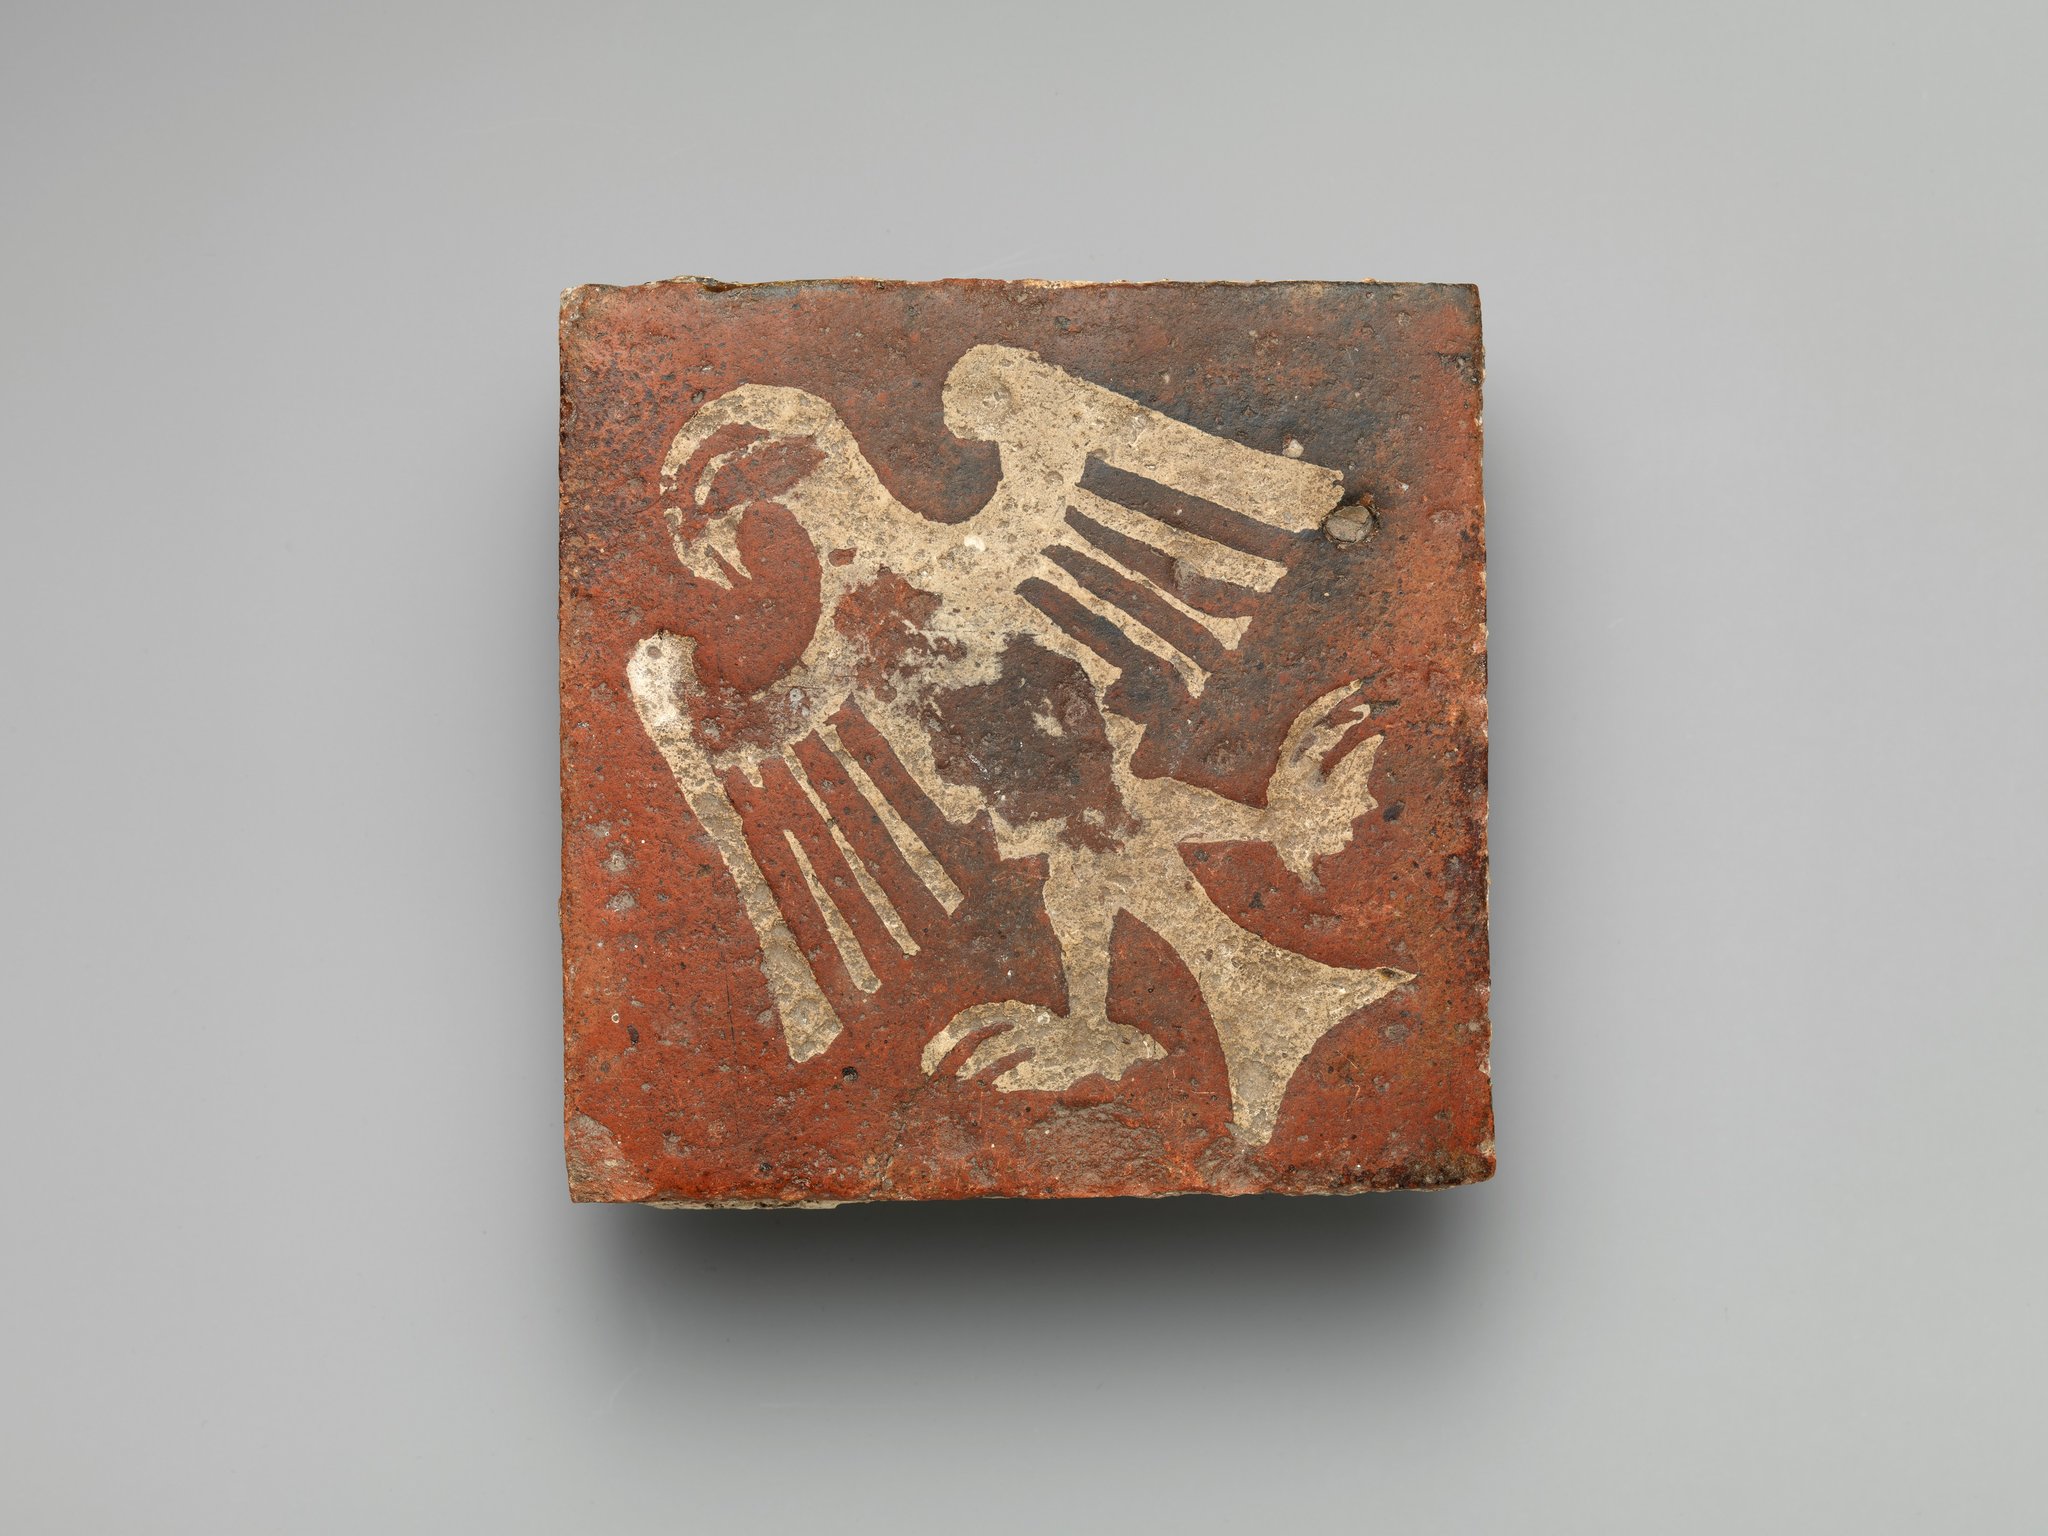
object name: tile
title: Tile with Eagle Motif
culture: british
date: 1267-1400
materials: earthenware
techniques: glazing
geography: england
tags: eagles